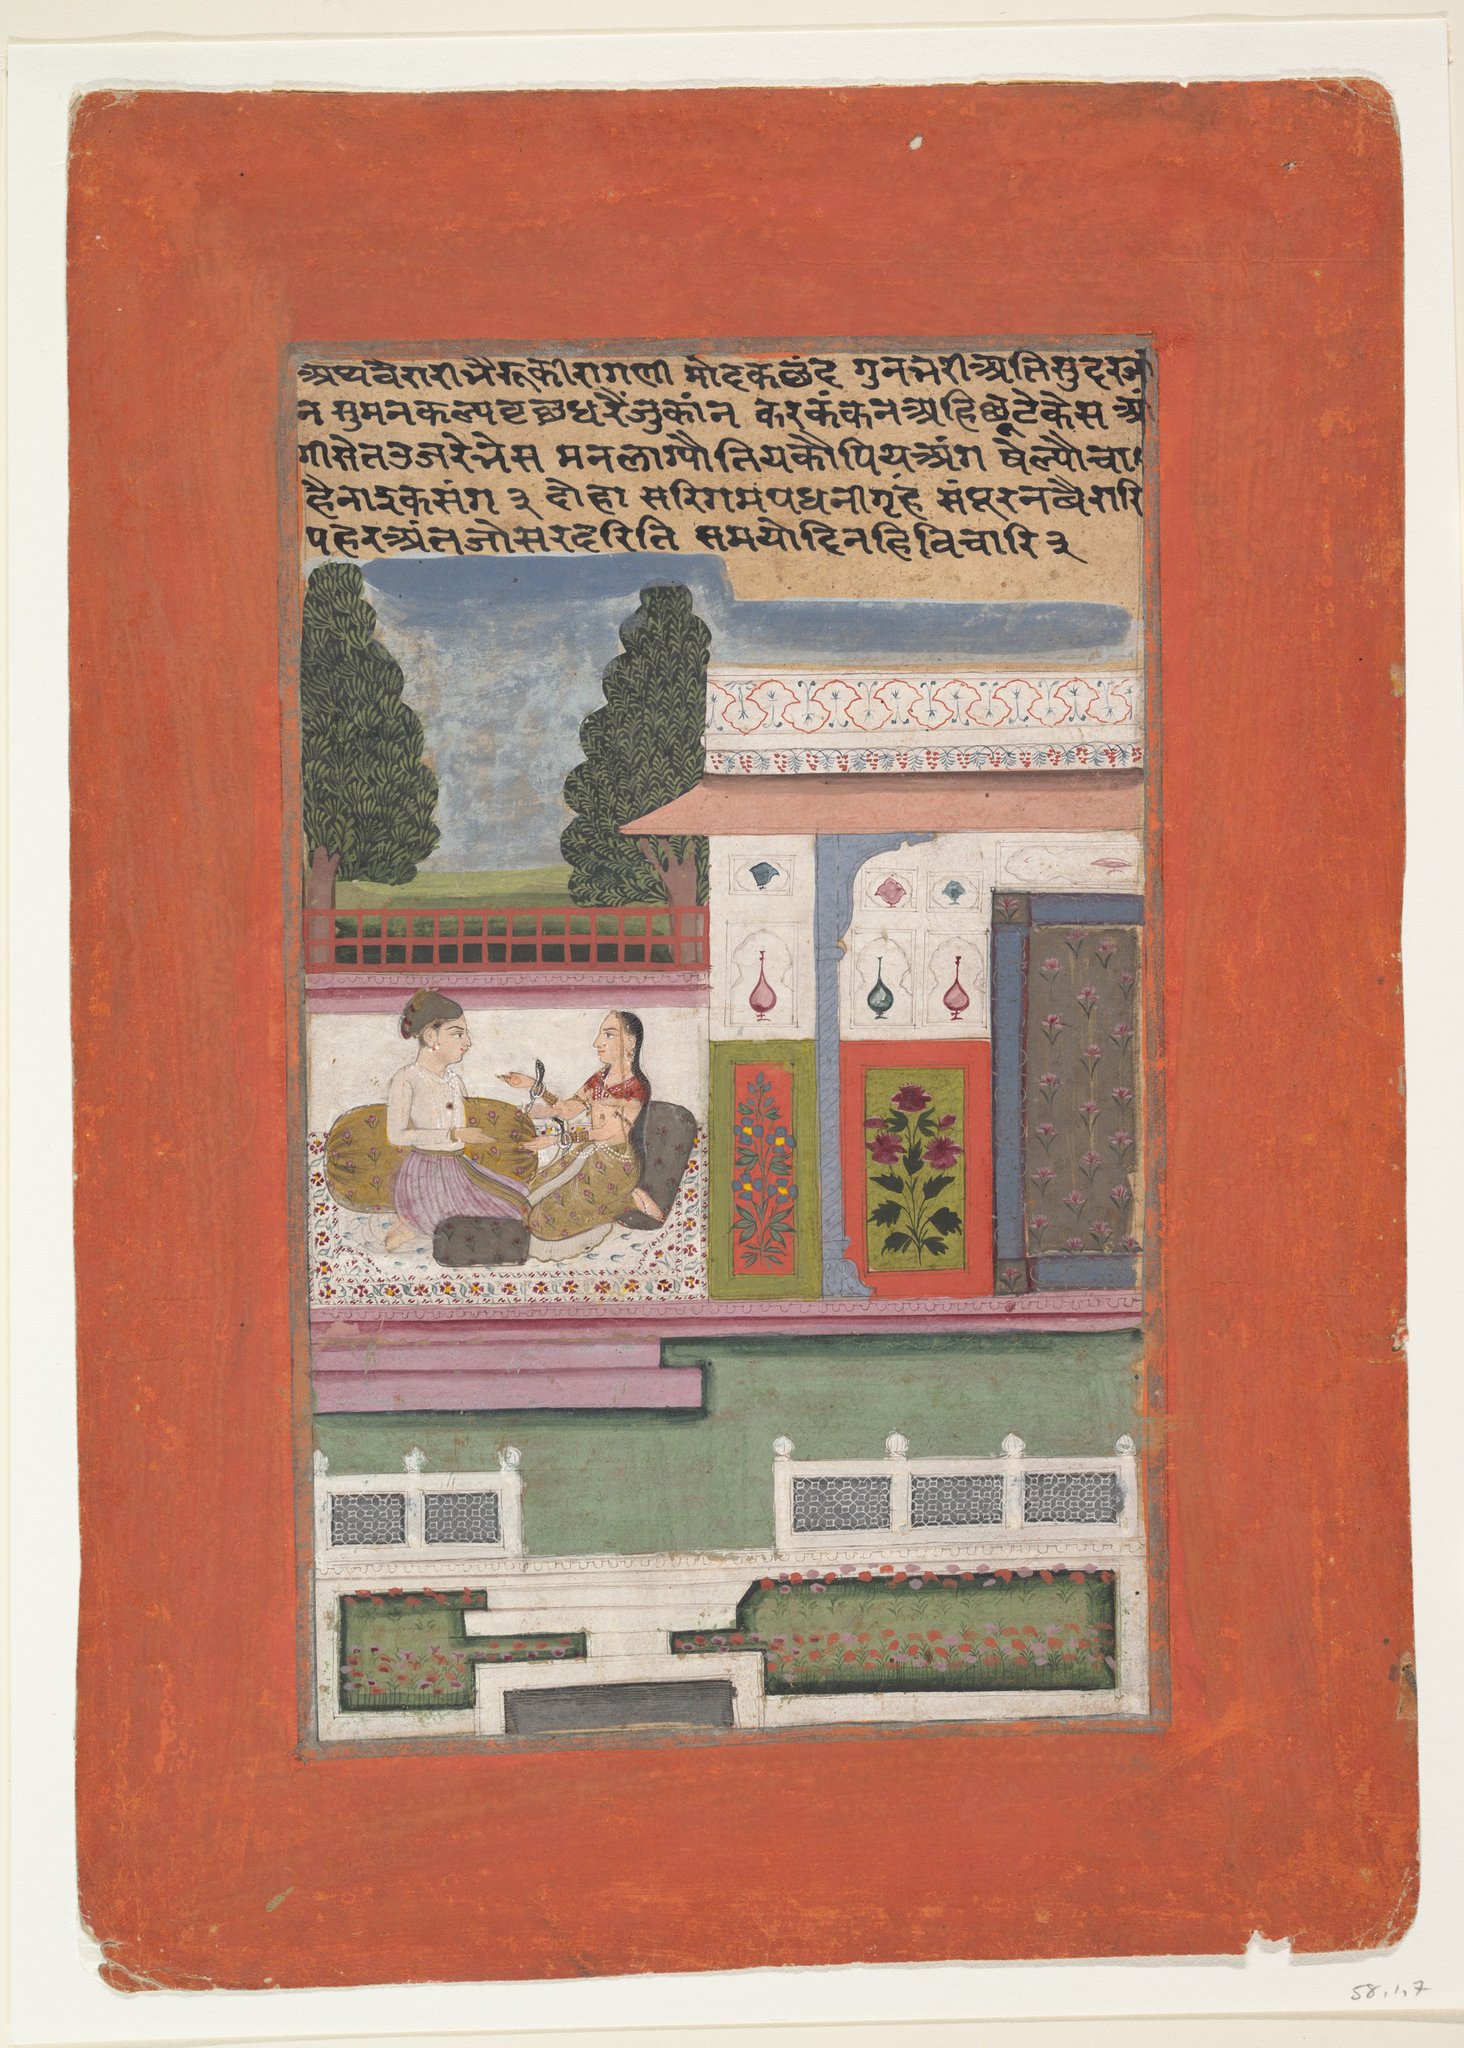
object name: folio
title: Vairari Ragini, Wife of Bhairav Raga: Page from a Dispersed Ragamala Series (Garland of Musical Modes)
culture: indian or rajasthan or amber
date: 1701-1733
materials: gilt, ink, paper, watercolor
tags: men,women